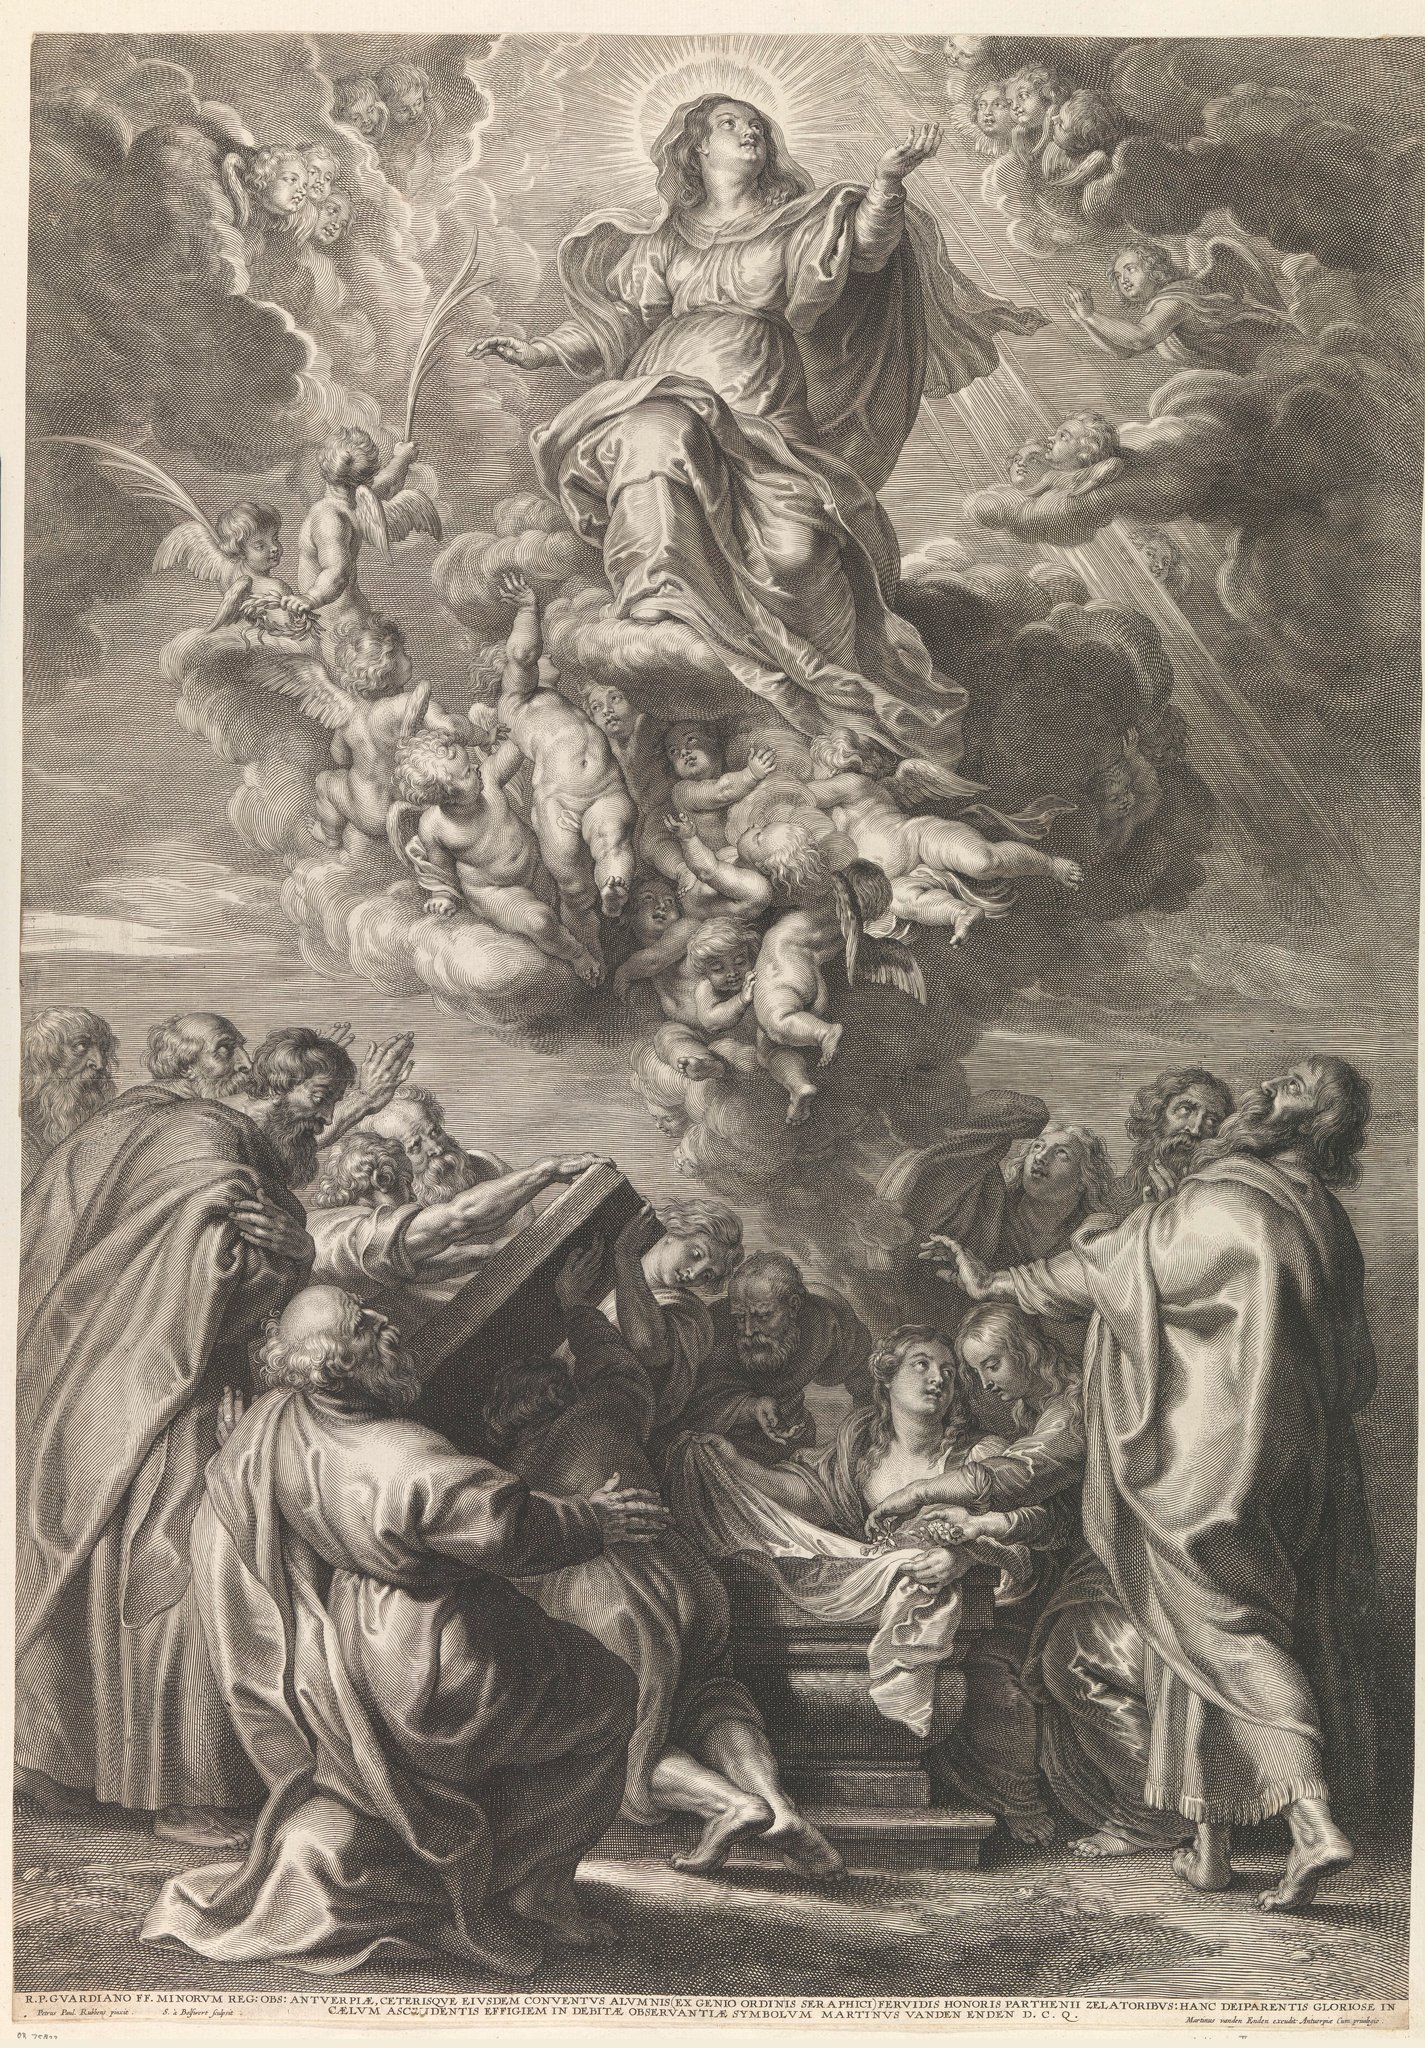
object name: album leaf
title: Hemelvaart van Maria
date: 1596-1659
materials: paper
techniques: engraving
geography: southern netherlands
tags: the assumption of mary ('assumptio corporis'): she is borne into heaven by angels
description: Hemelvaart van Maria met apostelen. In marge Latijns opschrift. Deze prent maakt deel uit van een album.